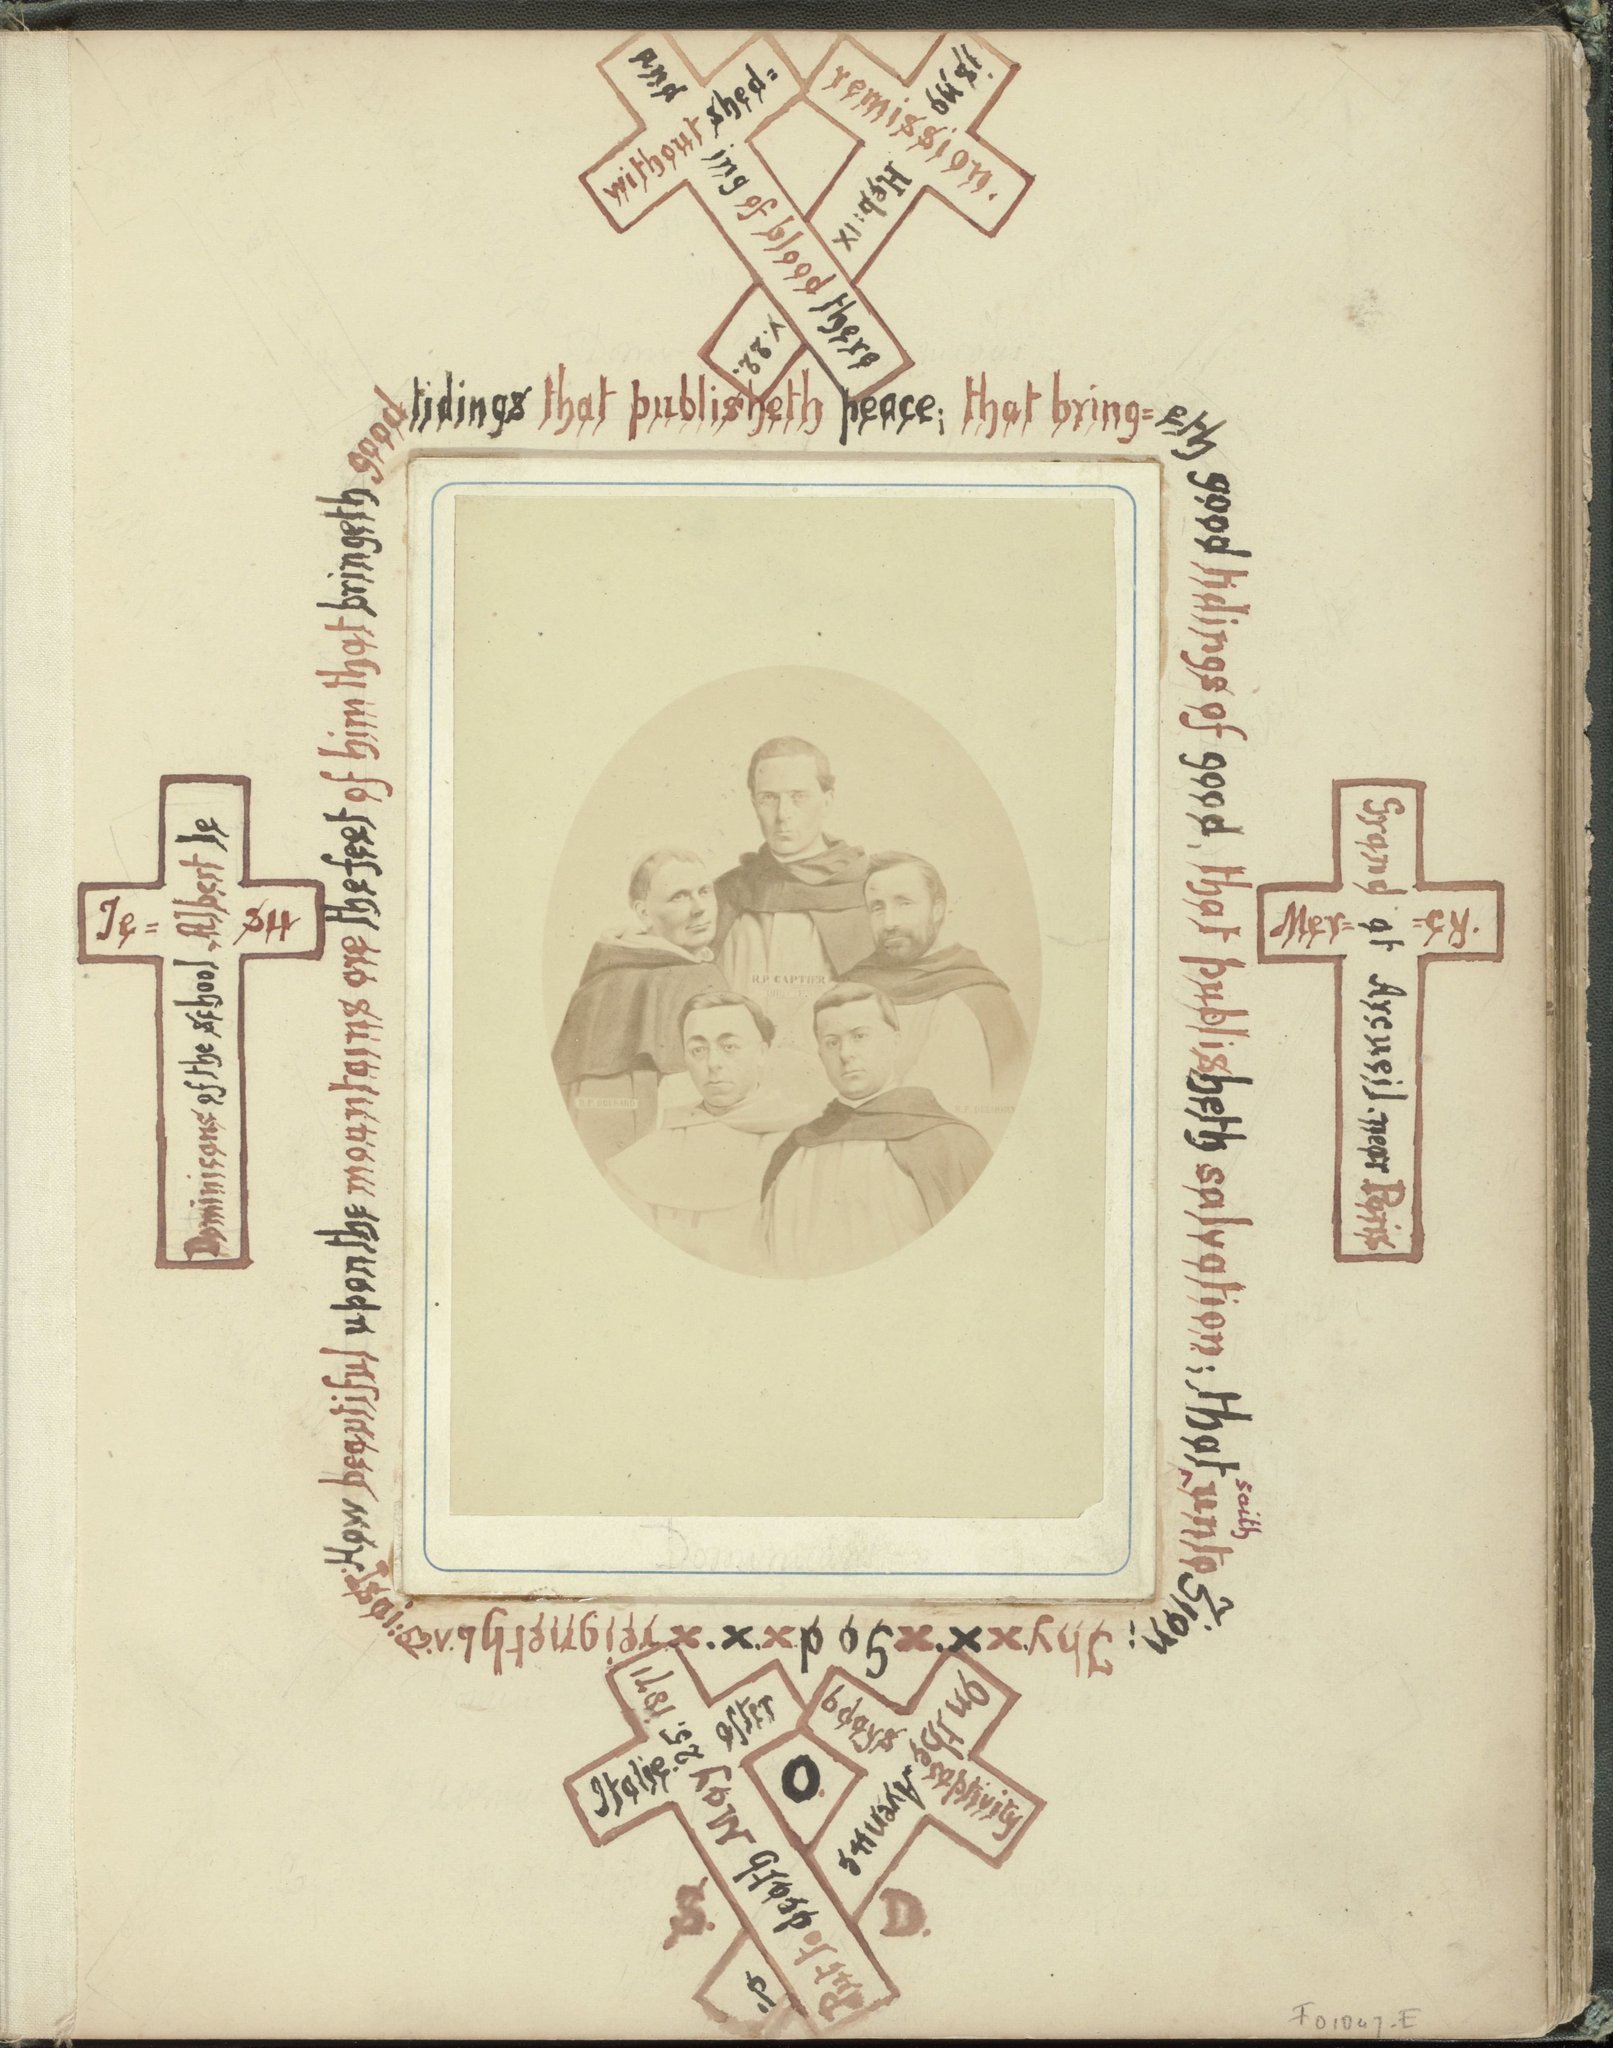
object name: album leaf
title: Fotomontage van vijf (vermoedelijk) getekende portretten van Dominicanen, omgeven door Engelse tekst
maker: Anonymous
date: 1871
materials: cardboard, paper, photographic support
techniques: albumen print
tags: monastic orders, monastic life: dominicans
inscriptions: inscription: ‘Domi[...]’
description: Onderdeel van Herdenkingsalbum van rooms-katholieke geestelijken gevallen tijdens de Commune van Parijs.